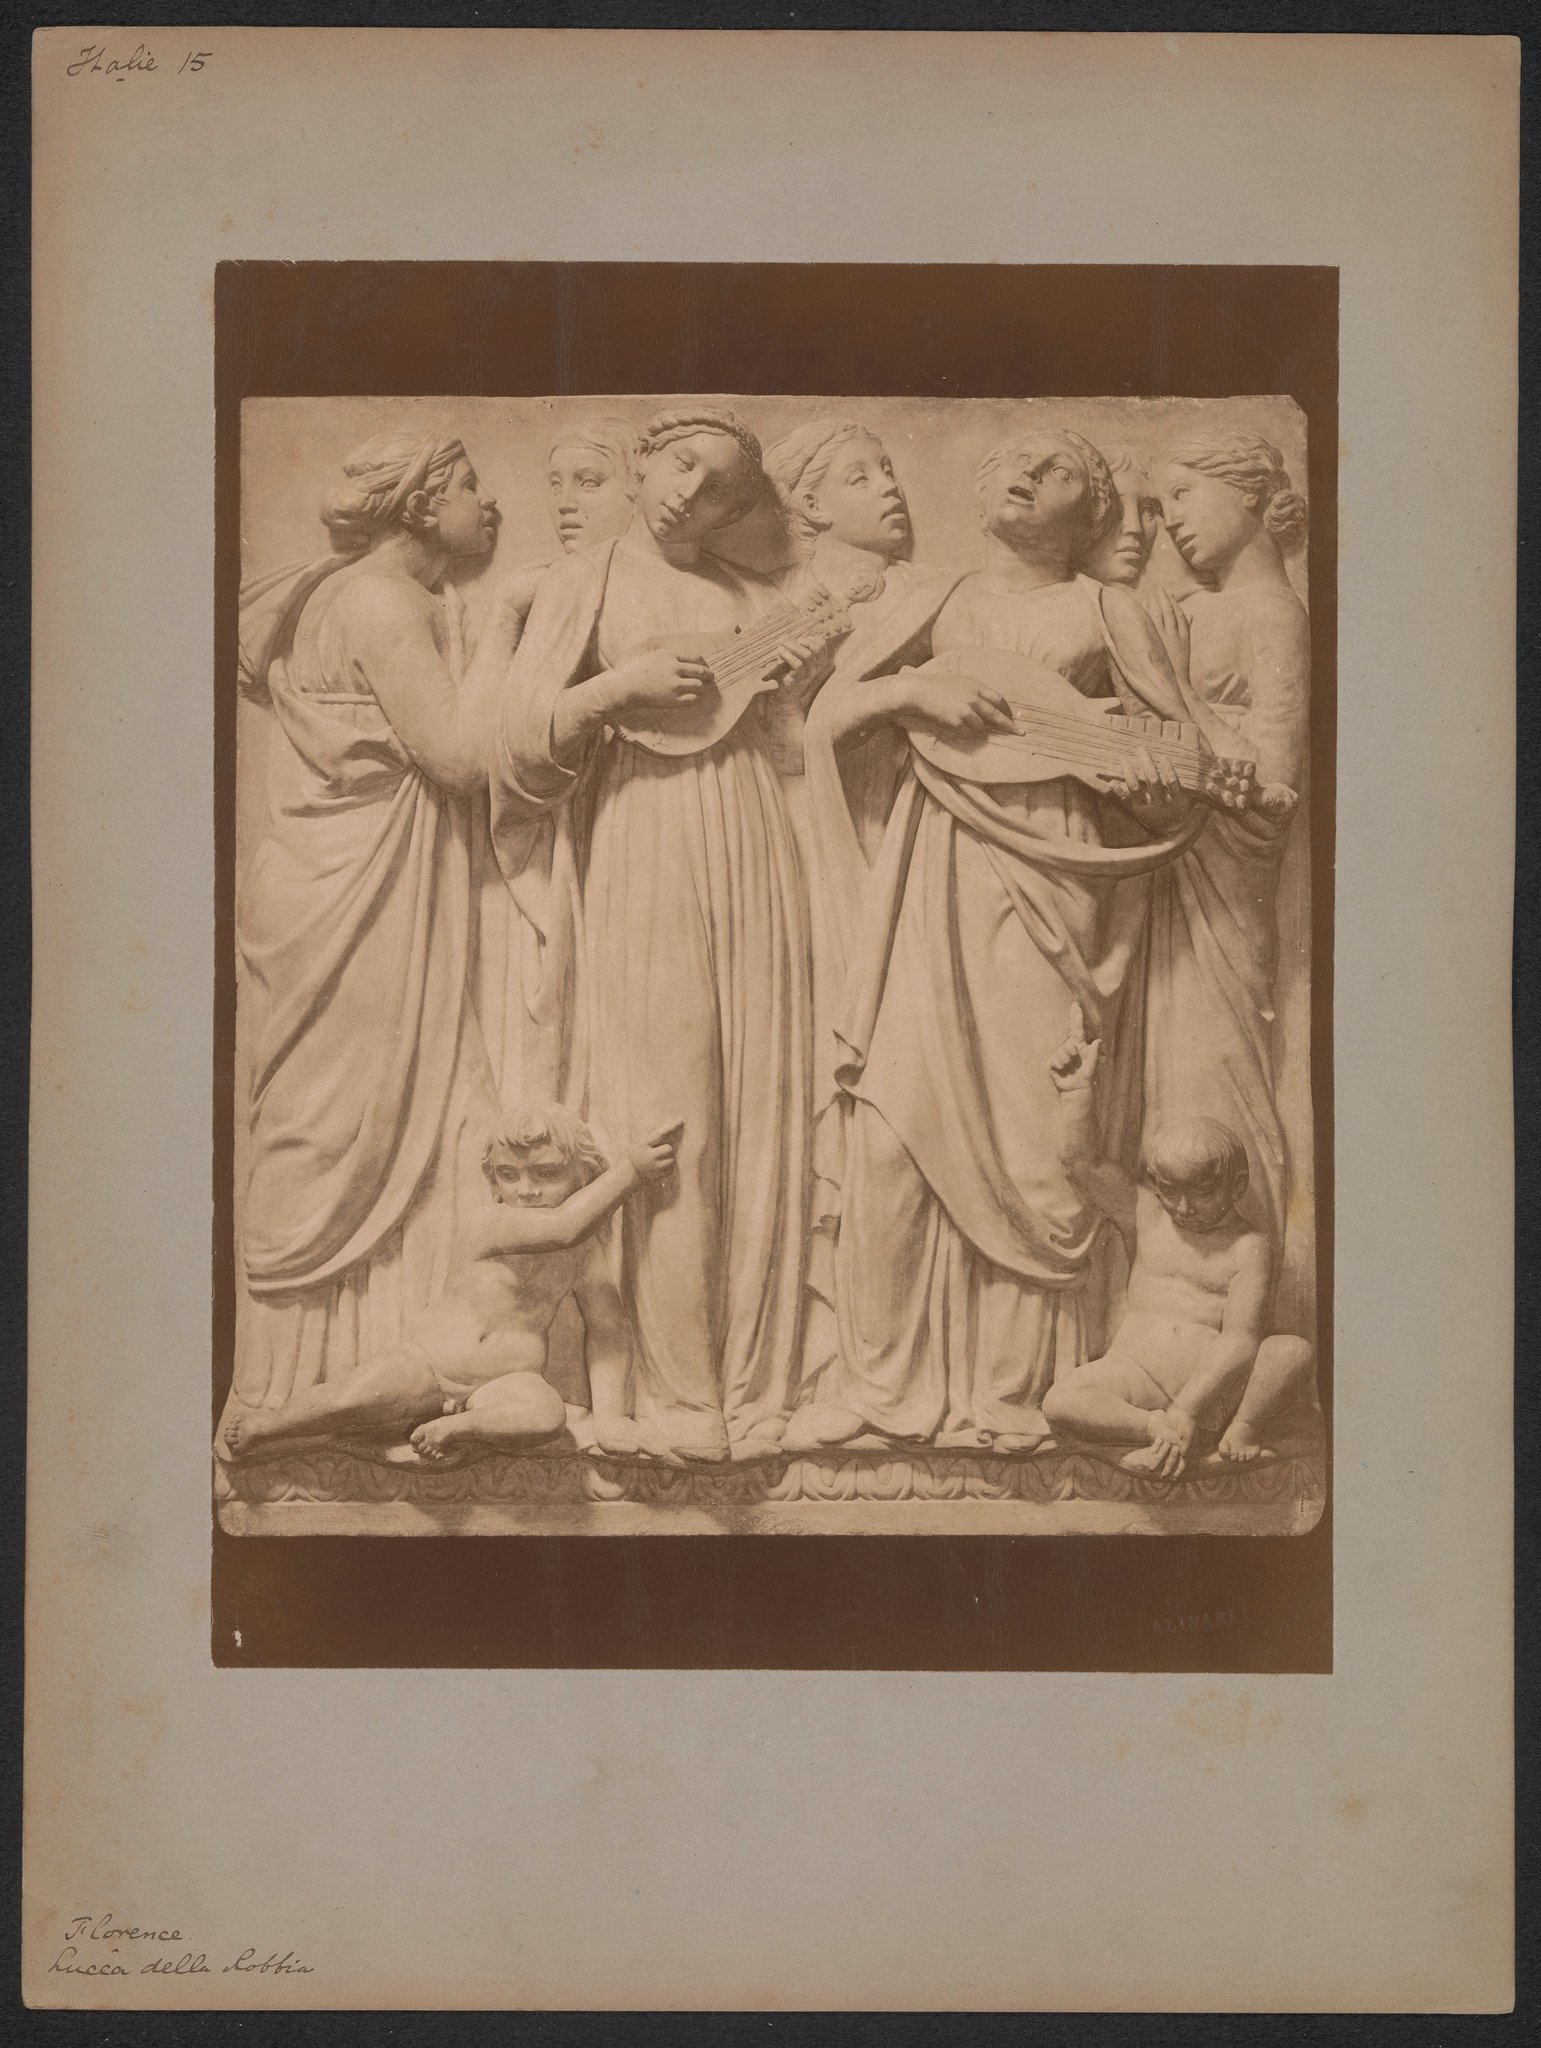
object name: photograph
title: De Cantoria door Lucca della Robbia in de Dom van Florence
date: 1850-1900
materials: cardboard, photographic support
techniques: albumen print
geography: florence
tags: string instruments (plucked), sculpture, choir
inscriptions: check stamp: ‘ALINARI’, annotation: ‘Italië 15’, annotation: ‘Florence./ Lucia della Robbia’, annotation: ‘Florence./ Luca della Robbia’, collector's mark: ‘[RIJKS NORMAALSCHOOL] voor [TEEKENONDERWIJZERS AMSTERDAM]’